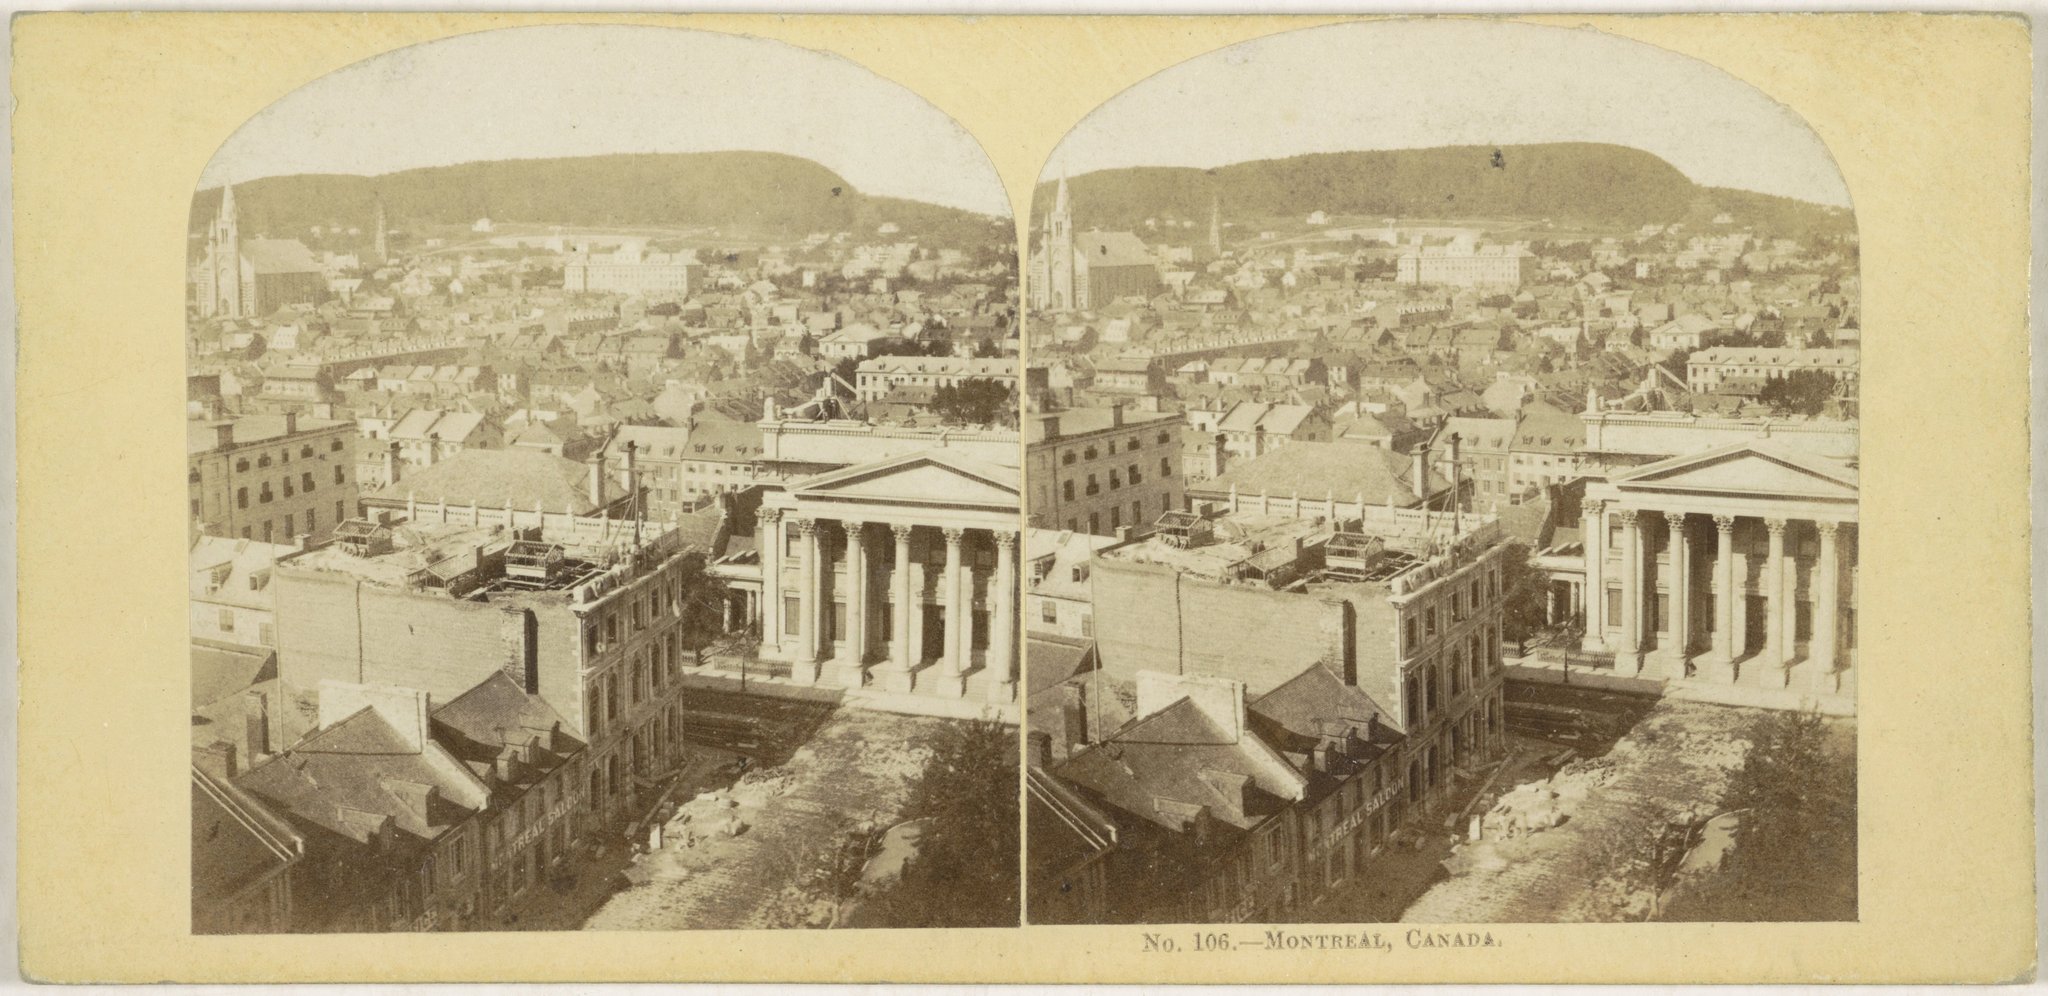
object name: stereograph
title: Montreal, Canada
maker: william england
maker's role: fotograaf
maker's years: 1816-1896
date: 1859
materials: cardboard, paper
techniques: albumen print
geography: montreal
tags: city-view in general; 'veduta'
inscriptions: number: ‘No. 106’, inscription: ‘Montreal, Canada. From the Cathedral, looking West. Jacques Cartier, the first European (...) it takes its name.’